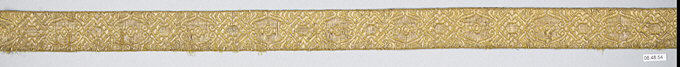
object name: galloon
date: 1601-1633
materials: metal thread